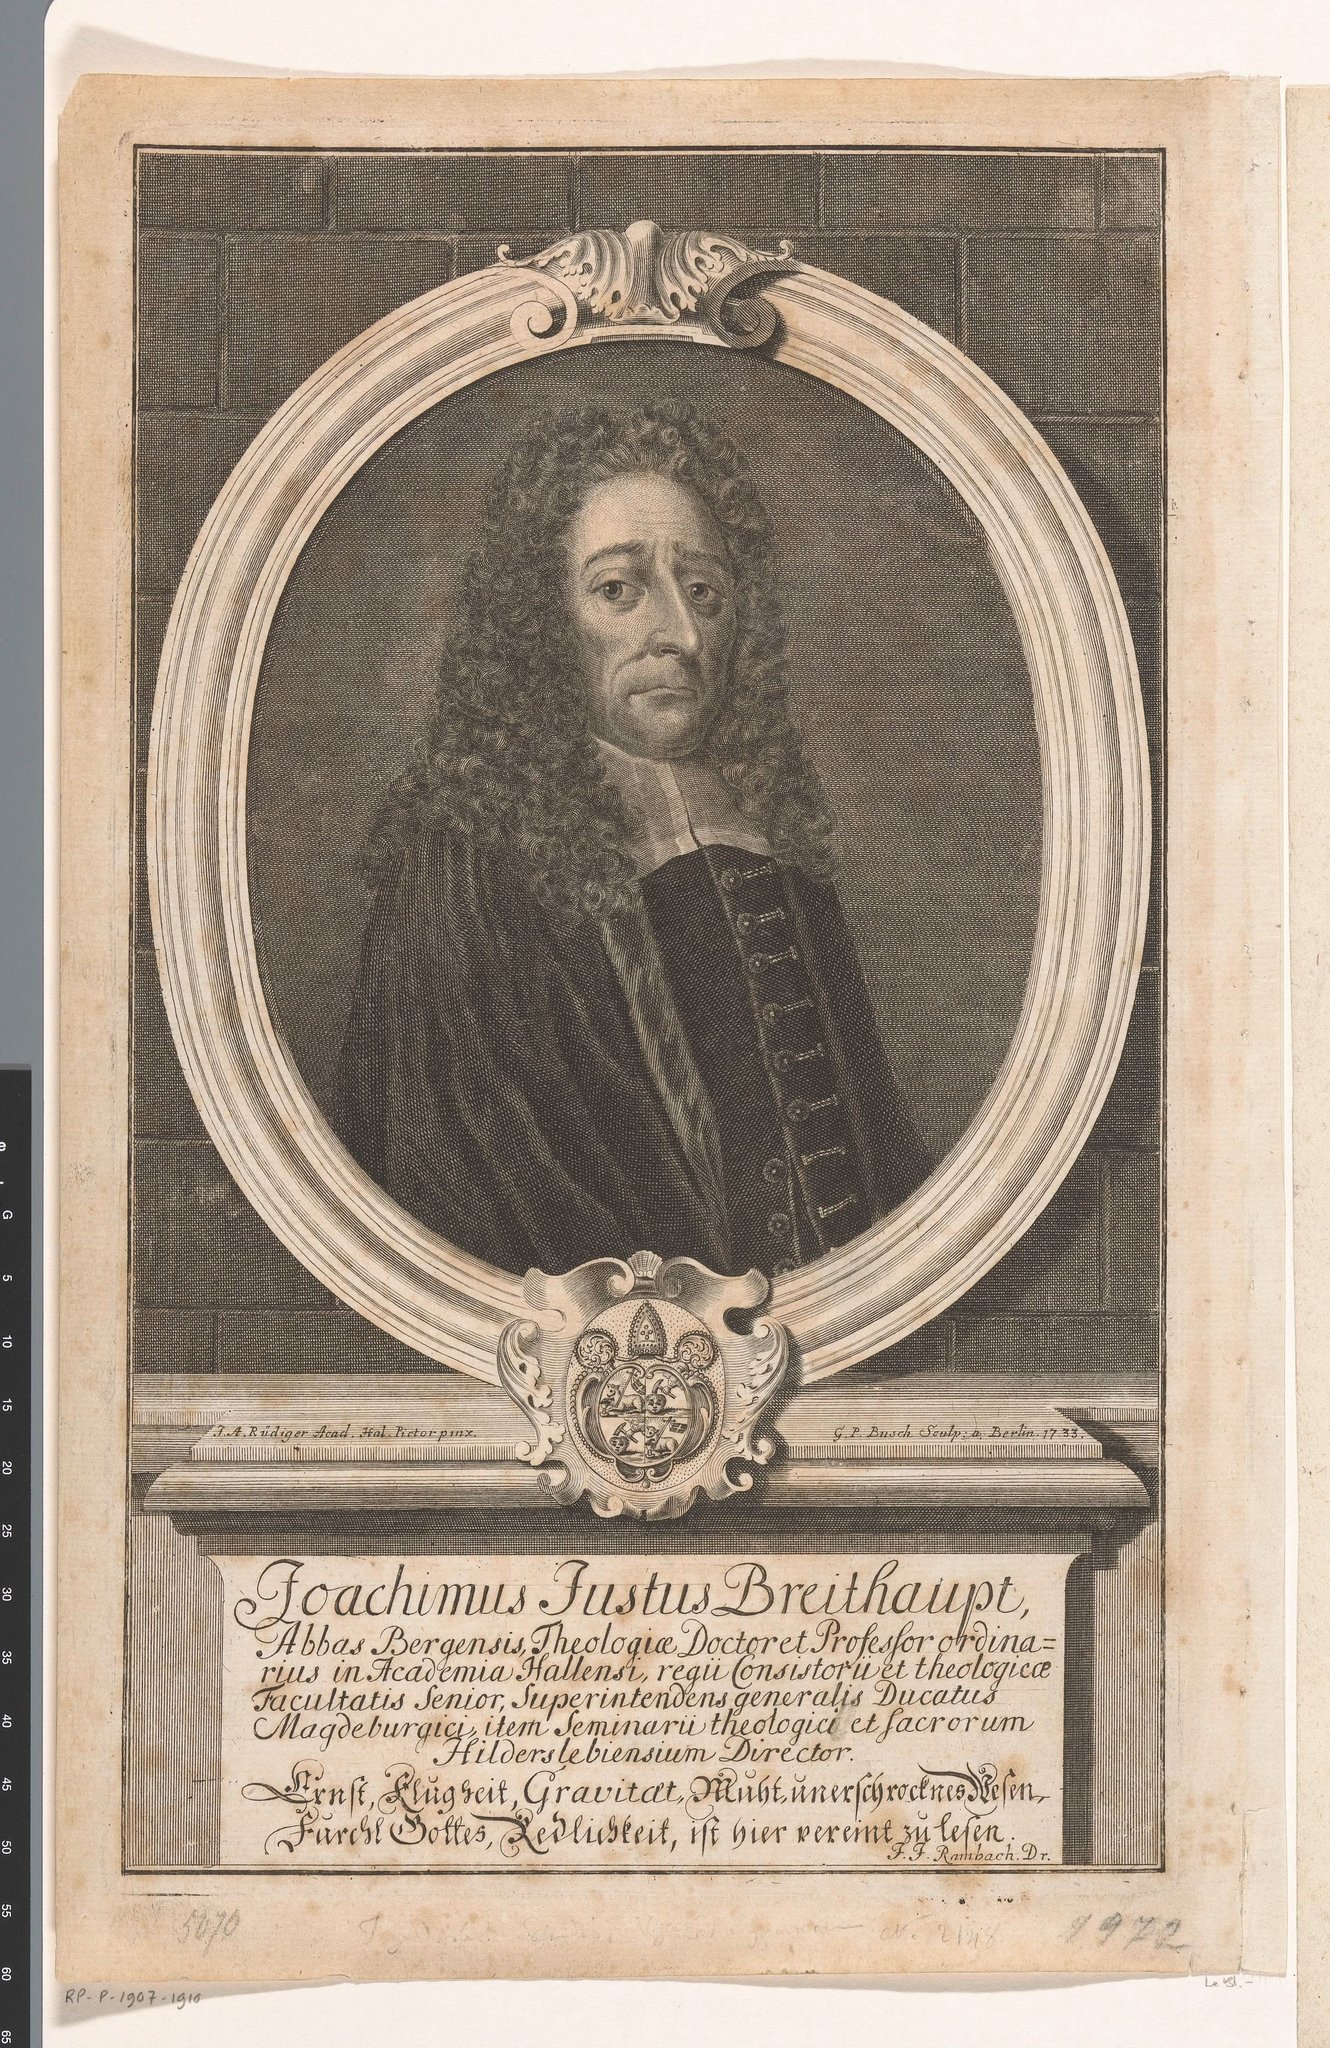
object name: print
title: Portret van Joachimi Justus Breithaupt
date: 1733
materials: paper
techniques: engraving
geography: berlin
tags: joachim justus breithaupt, historical persons, armorial bearing, heraldry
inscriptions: collector's mark: Lugt 2228